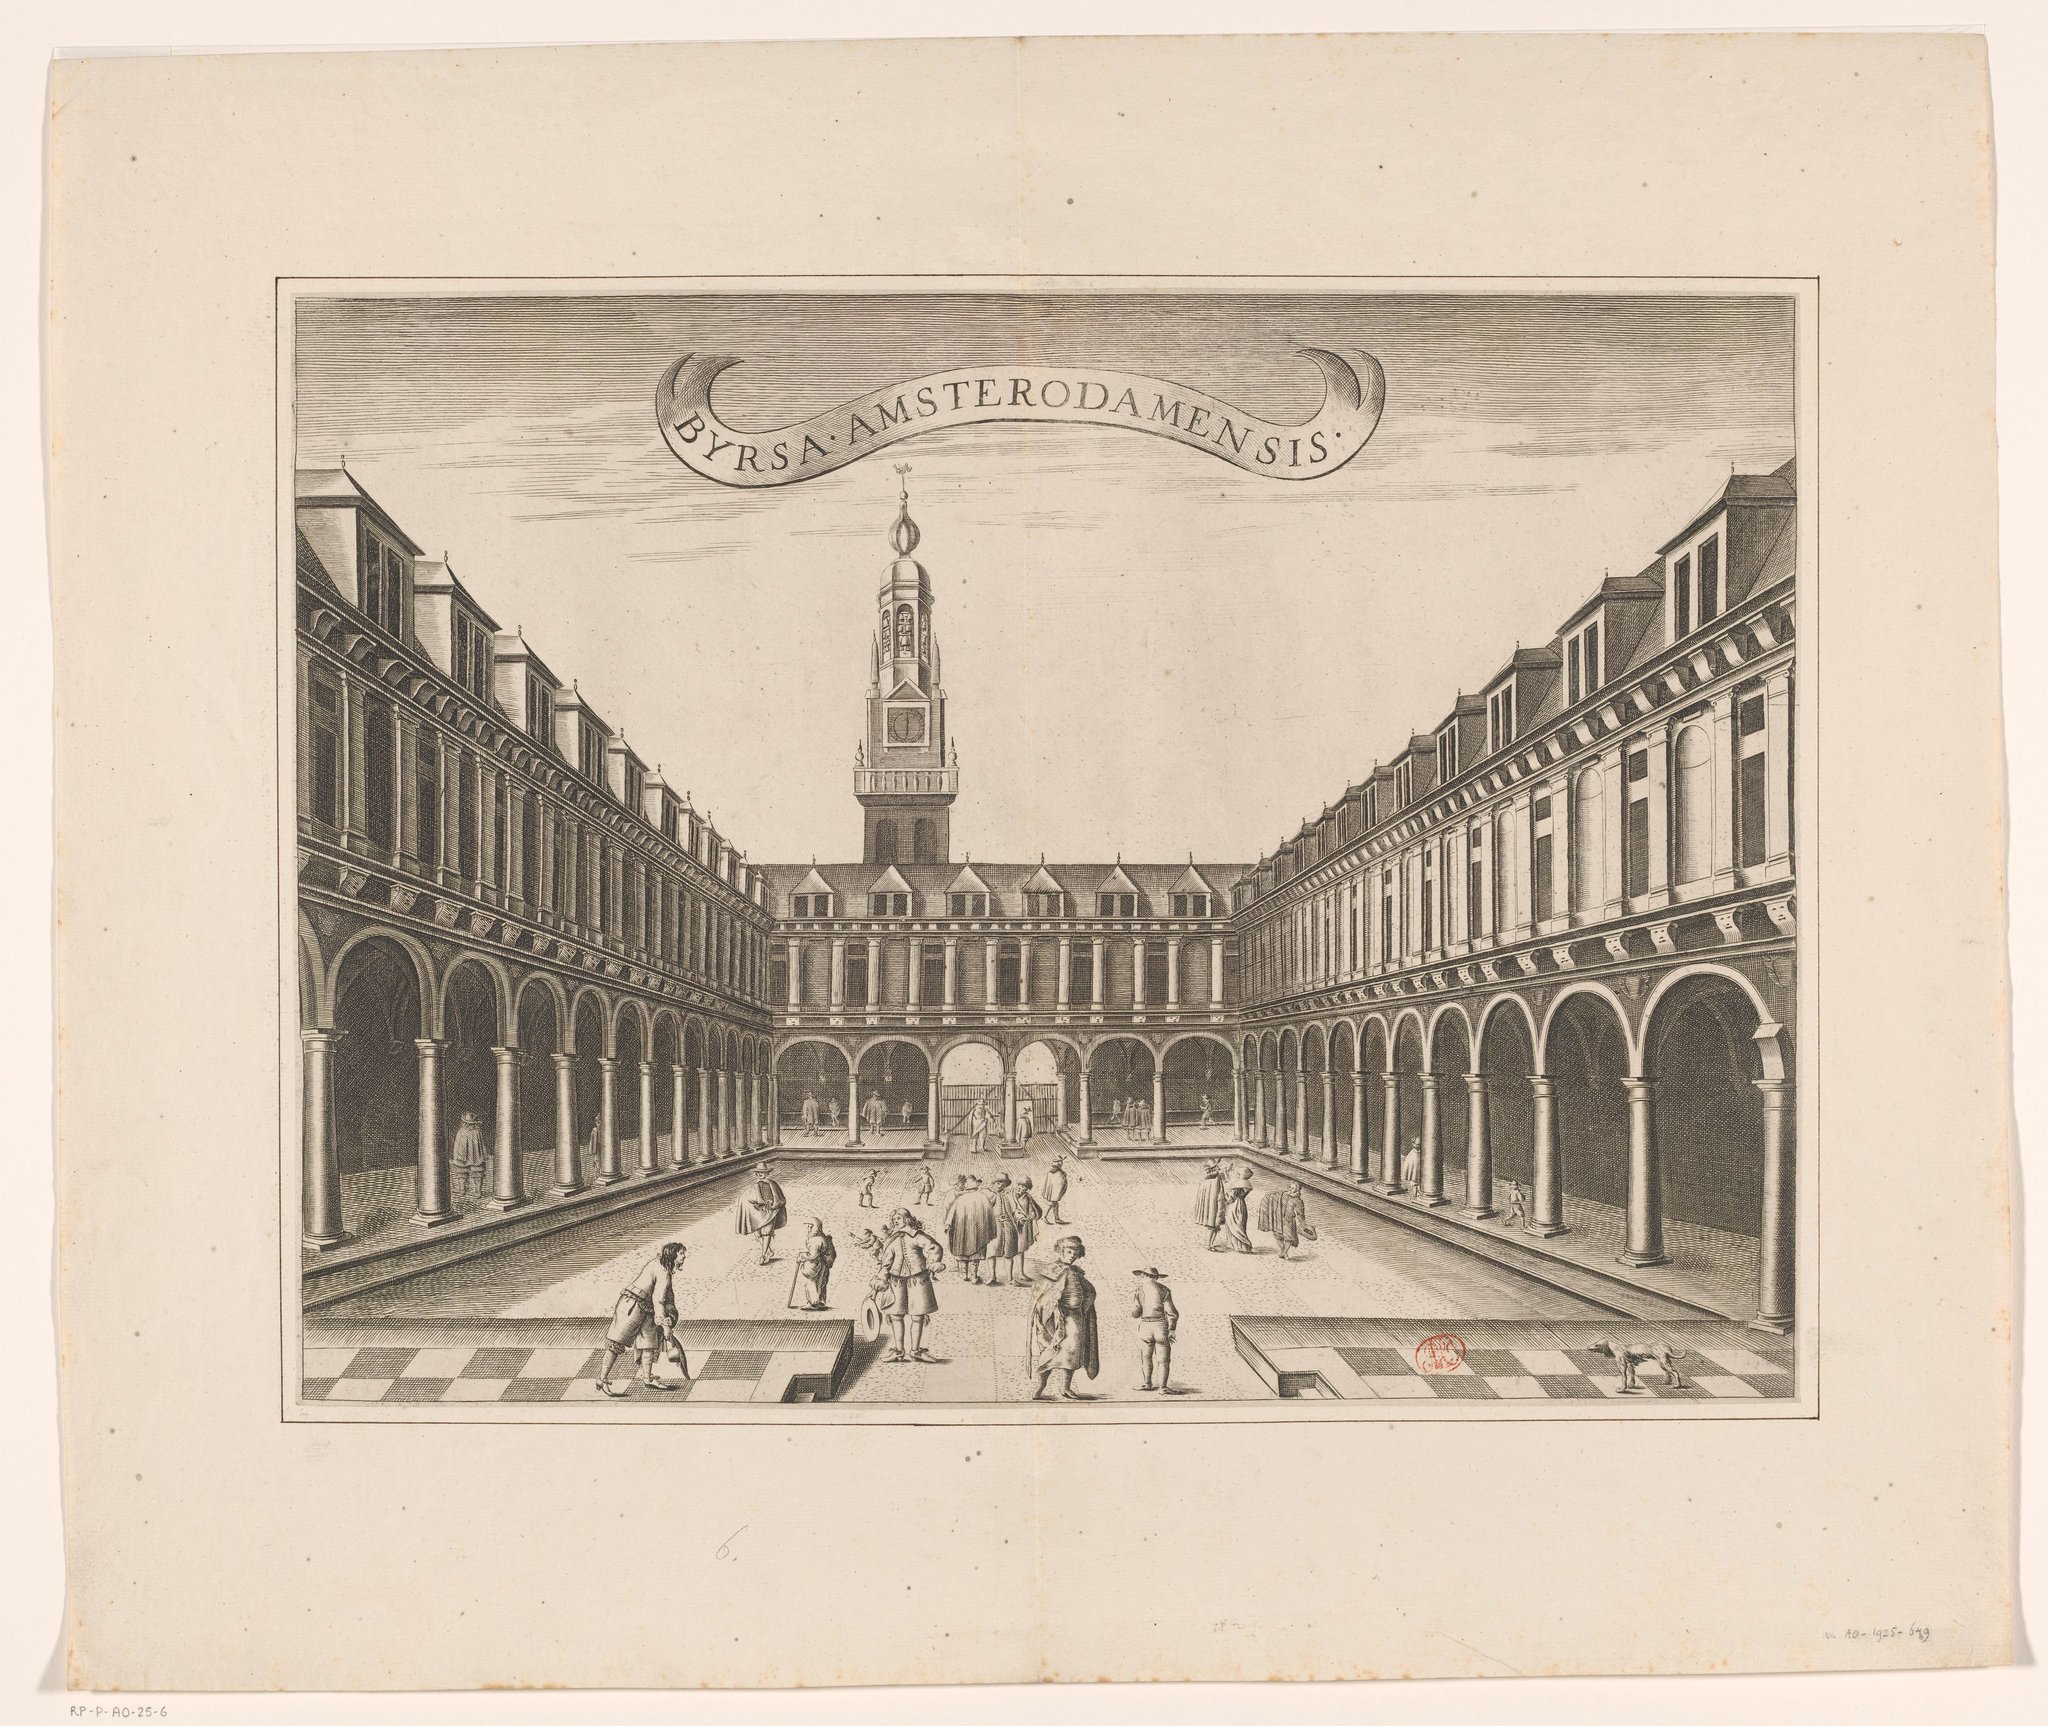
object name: print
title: Byrsa Amsterodamensis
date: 1640-1668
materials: paper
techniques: engraving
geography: amsterdam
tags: courtyard, exchange, bourse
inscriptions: collector's mark: Lugt 195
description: Gezicht op de binnenplaats van de Beurs van Hendrik de Keyser, na de voltooiing van het gebouw in 1611 en voor de verbouwing van 1668. Op het plein verschillende figuren. Boven in het midden een banderol met de titel.